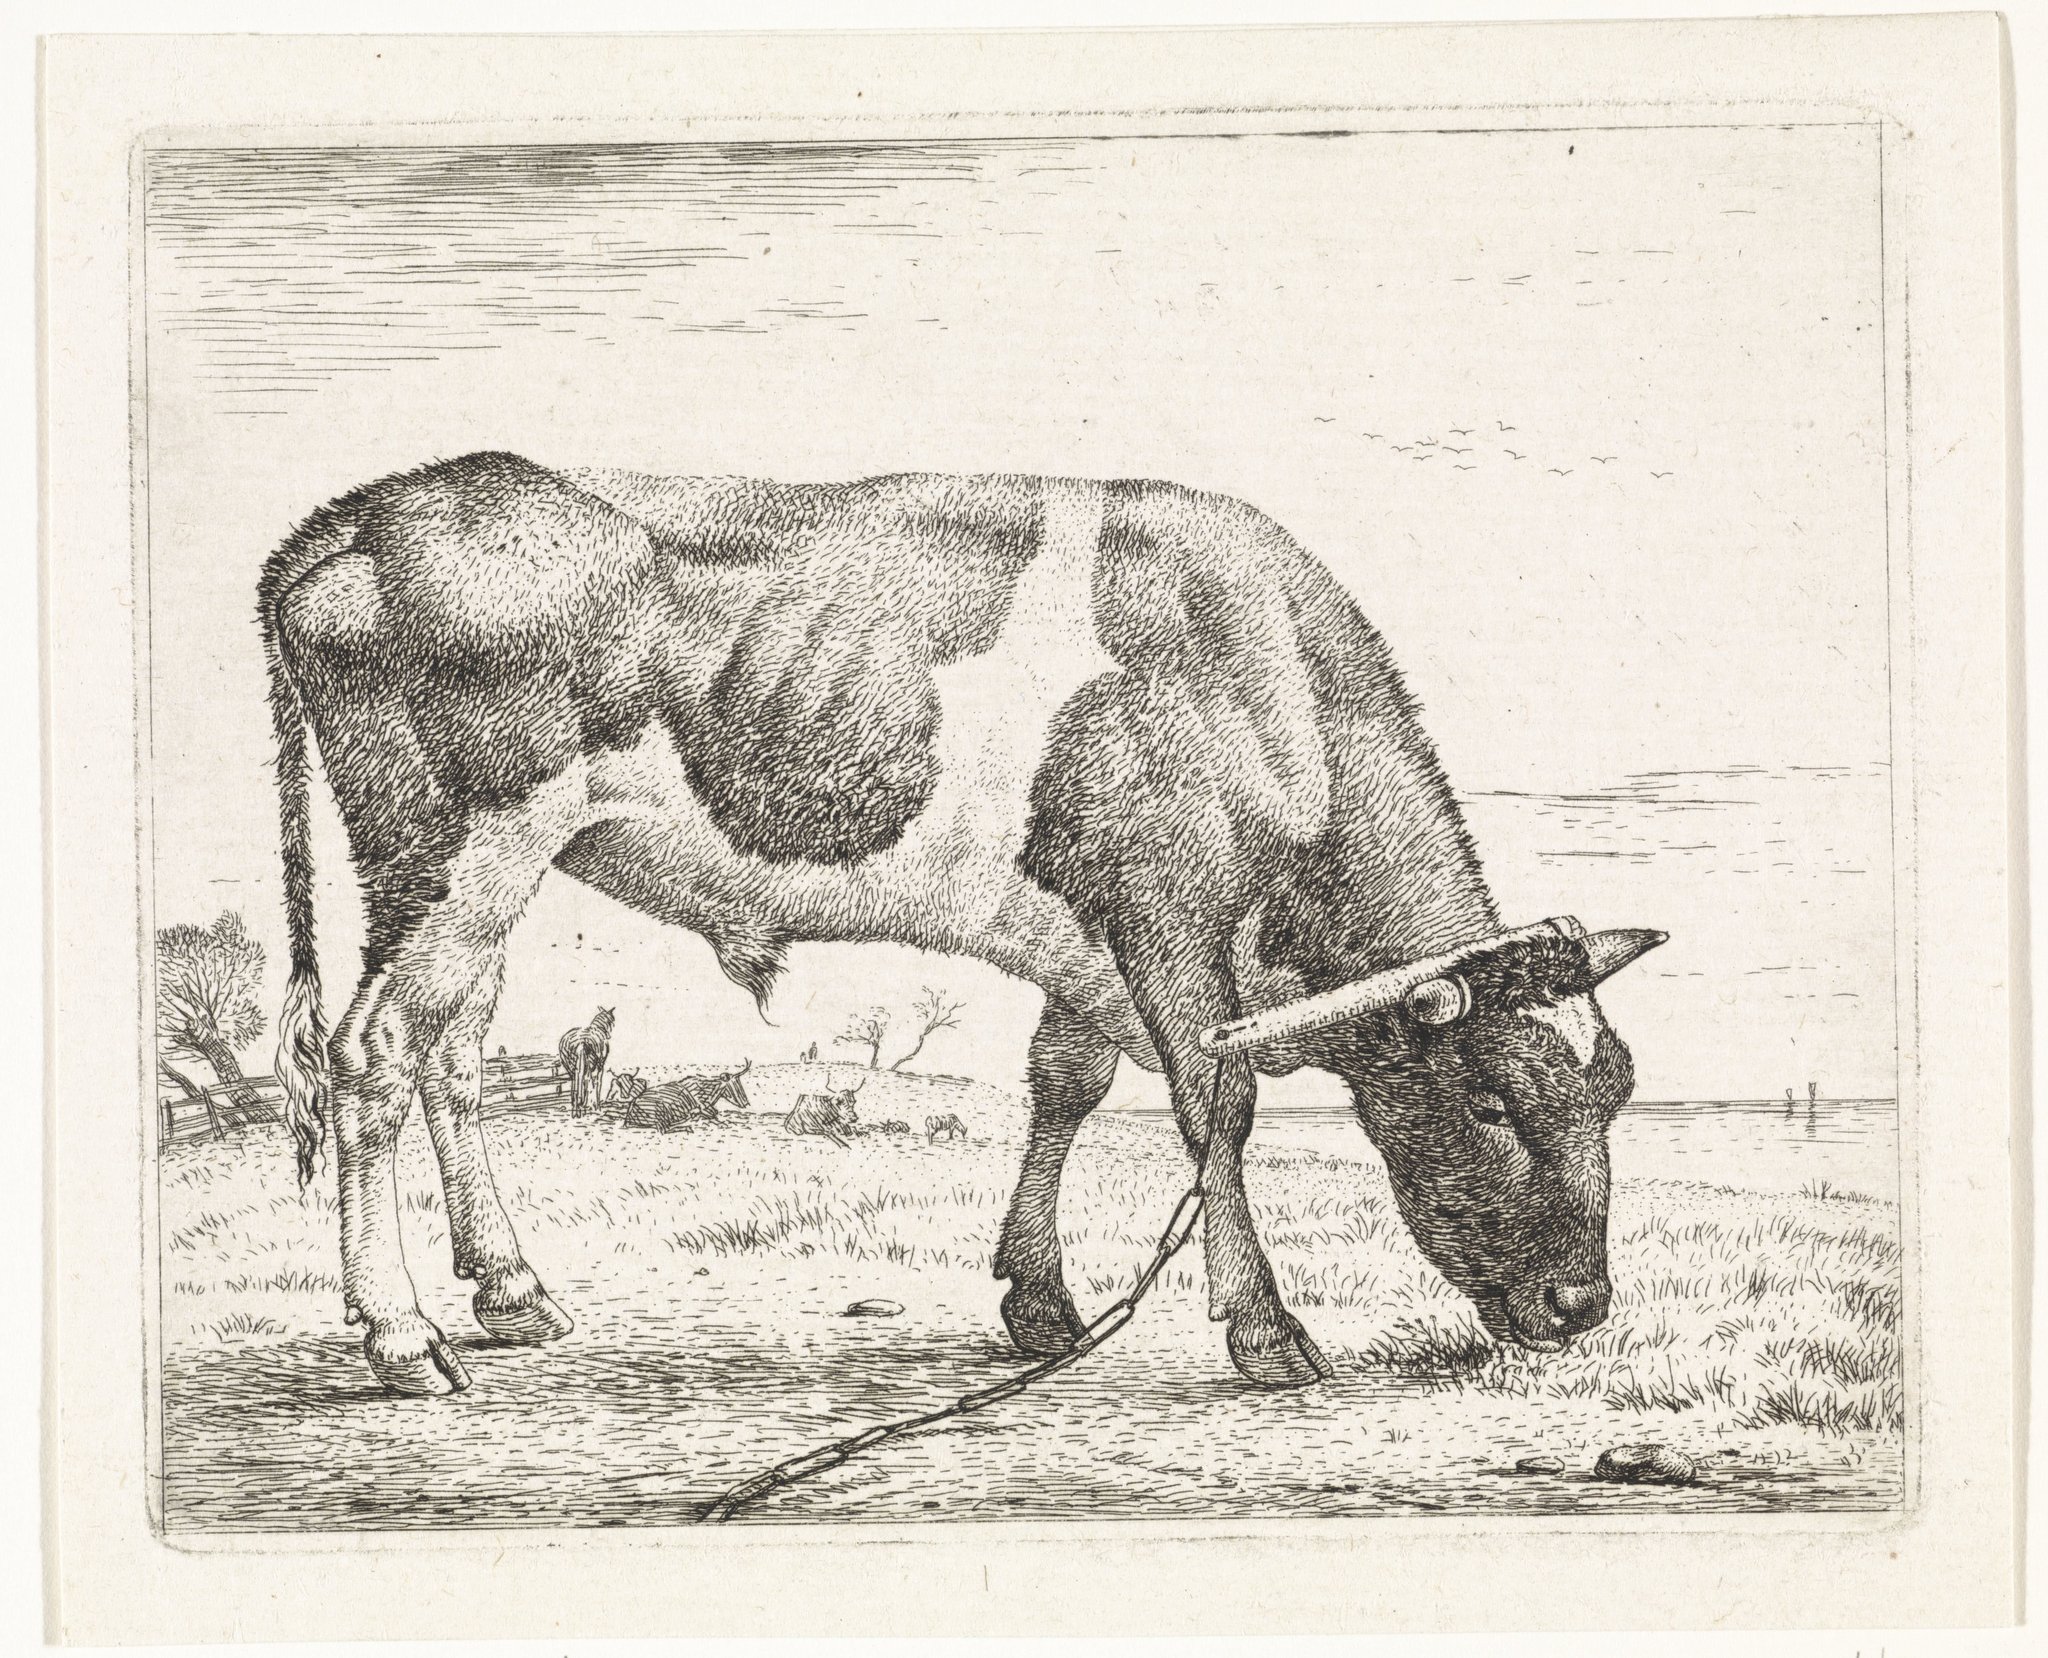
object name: print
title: Grazende os met een juk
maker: wouter johannes van troostwijk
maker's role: draughtsman, painter, print maker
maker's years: 1782-1810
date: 1792-1810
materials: paper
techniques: etching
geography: amsterdam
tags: ox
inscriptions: collector's mark: Lugt 2228